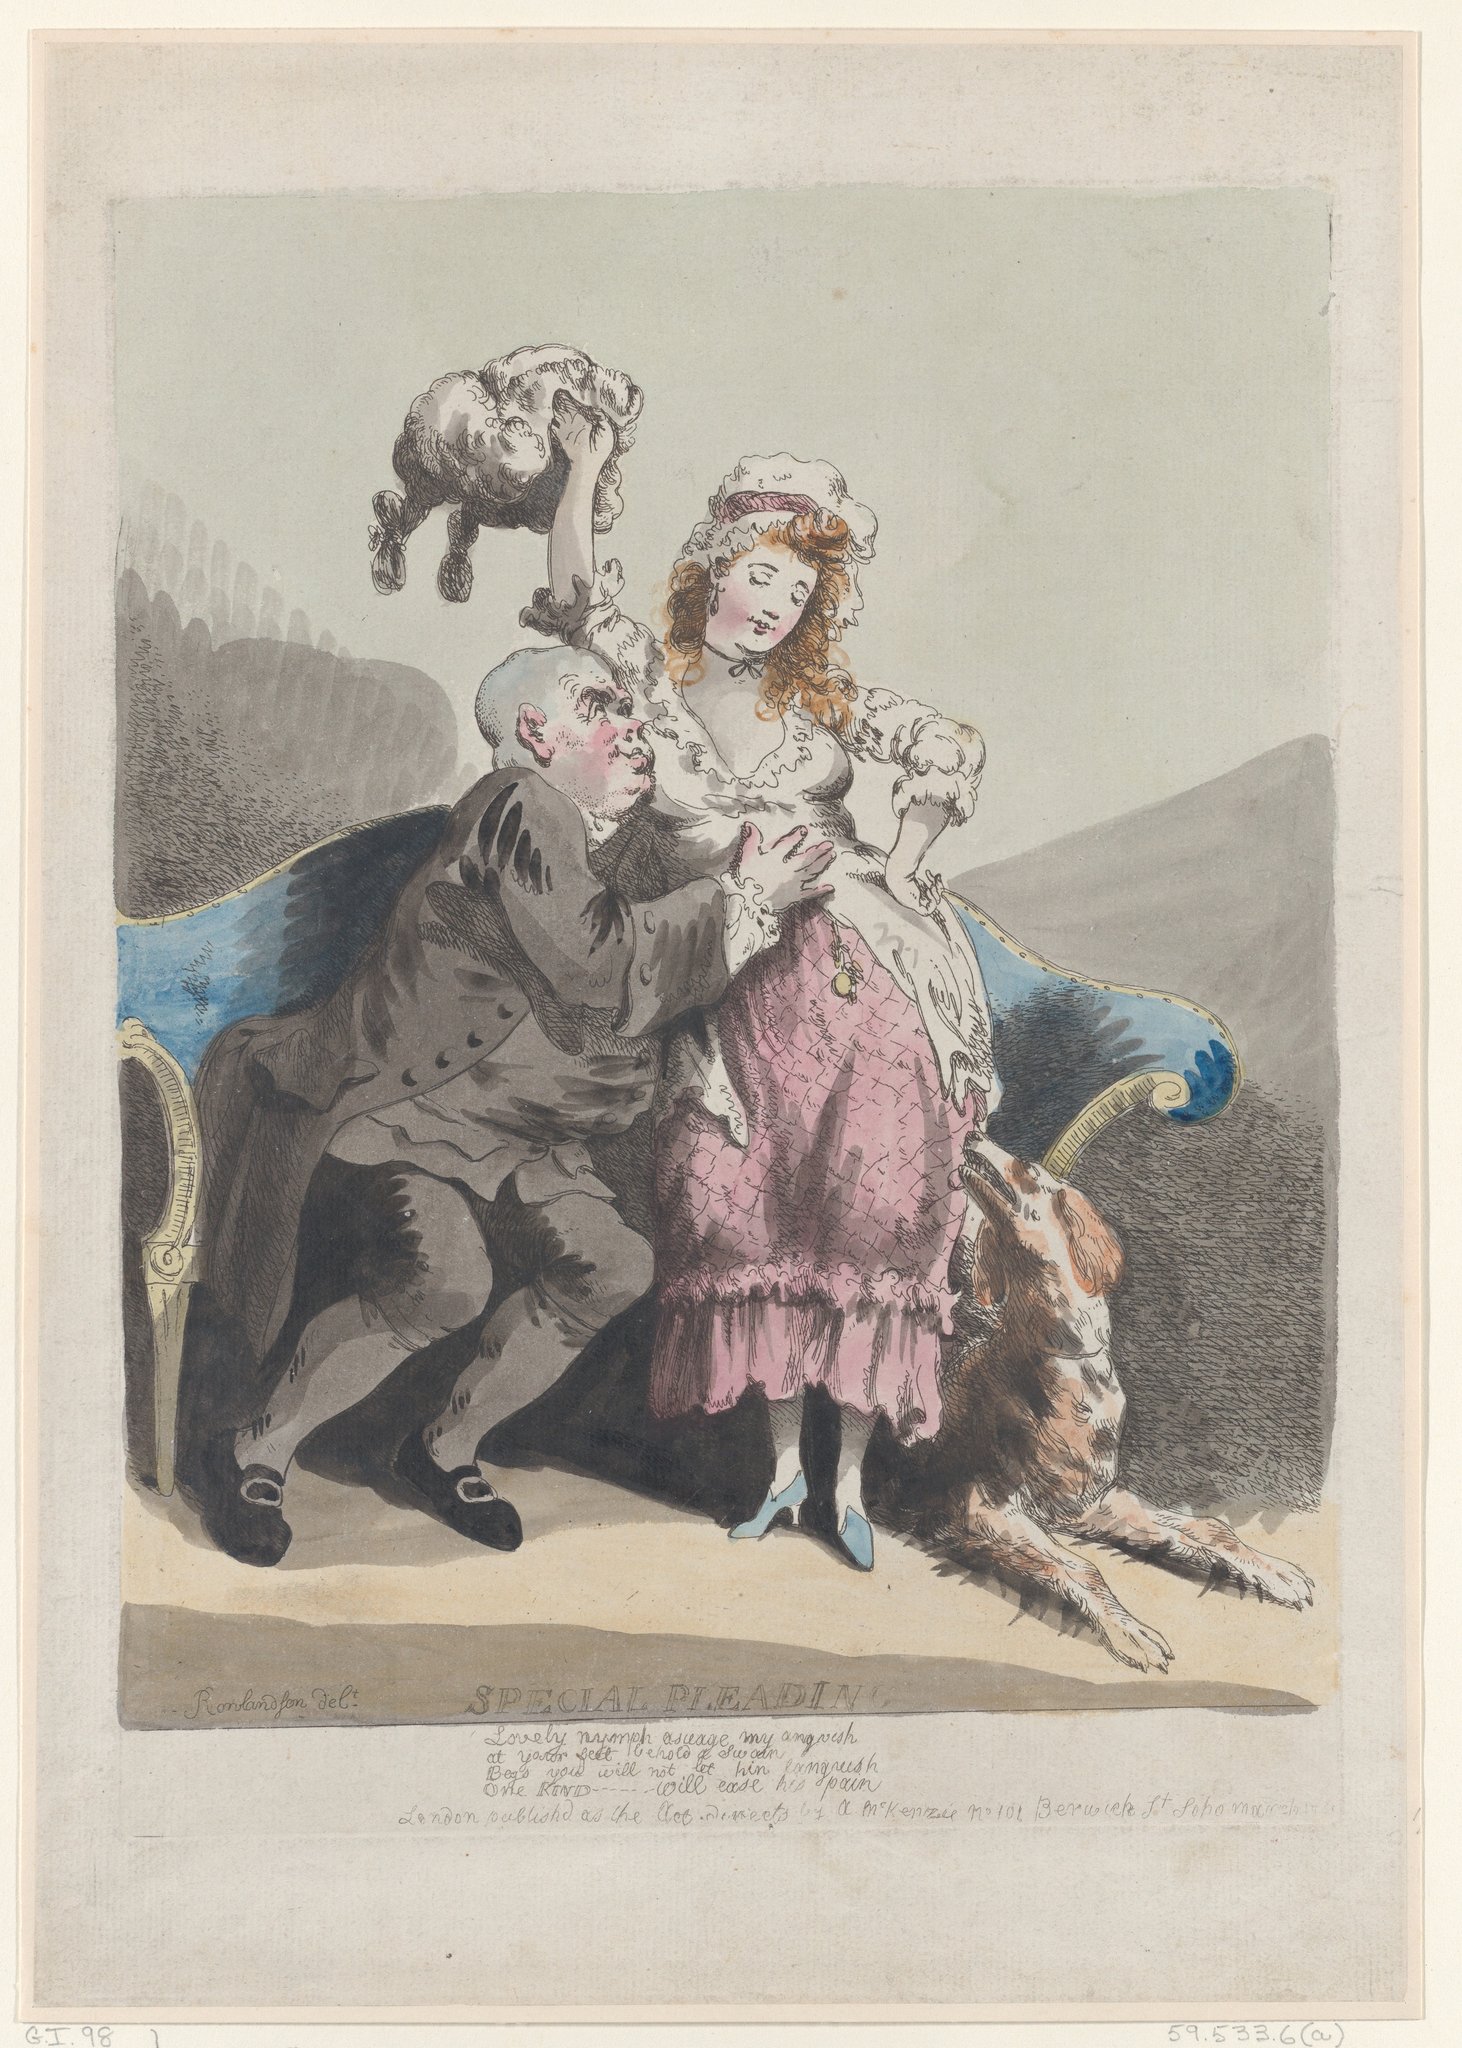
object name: print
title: Special Pleading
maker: thomas rowlandson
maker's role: artist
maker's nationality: british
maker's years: 1757-1827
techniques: aquatint, etching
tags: satire,men,women,dogs